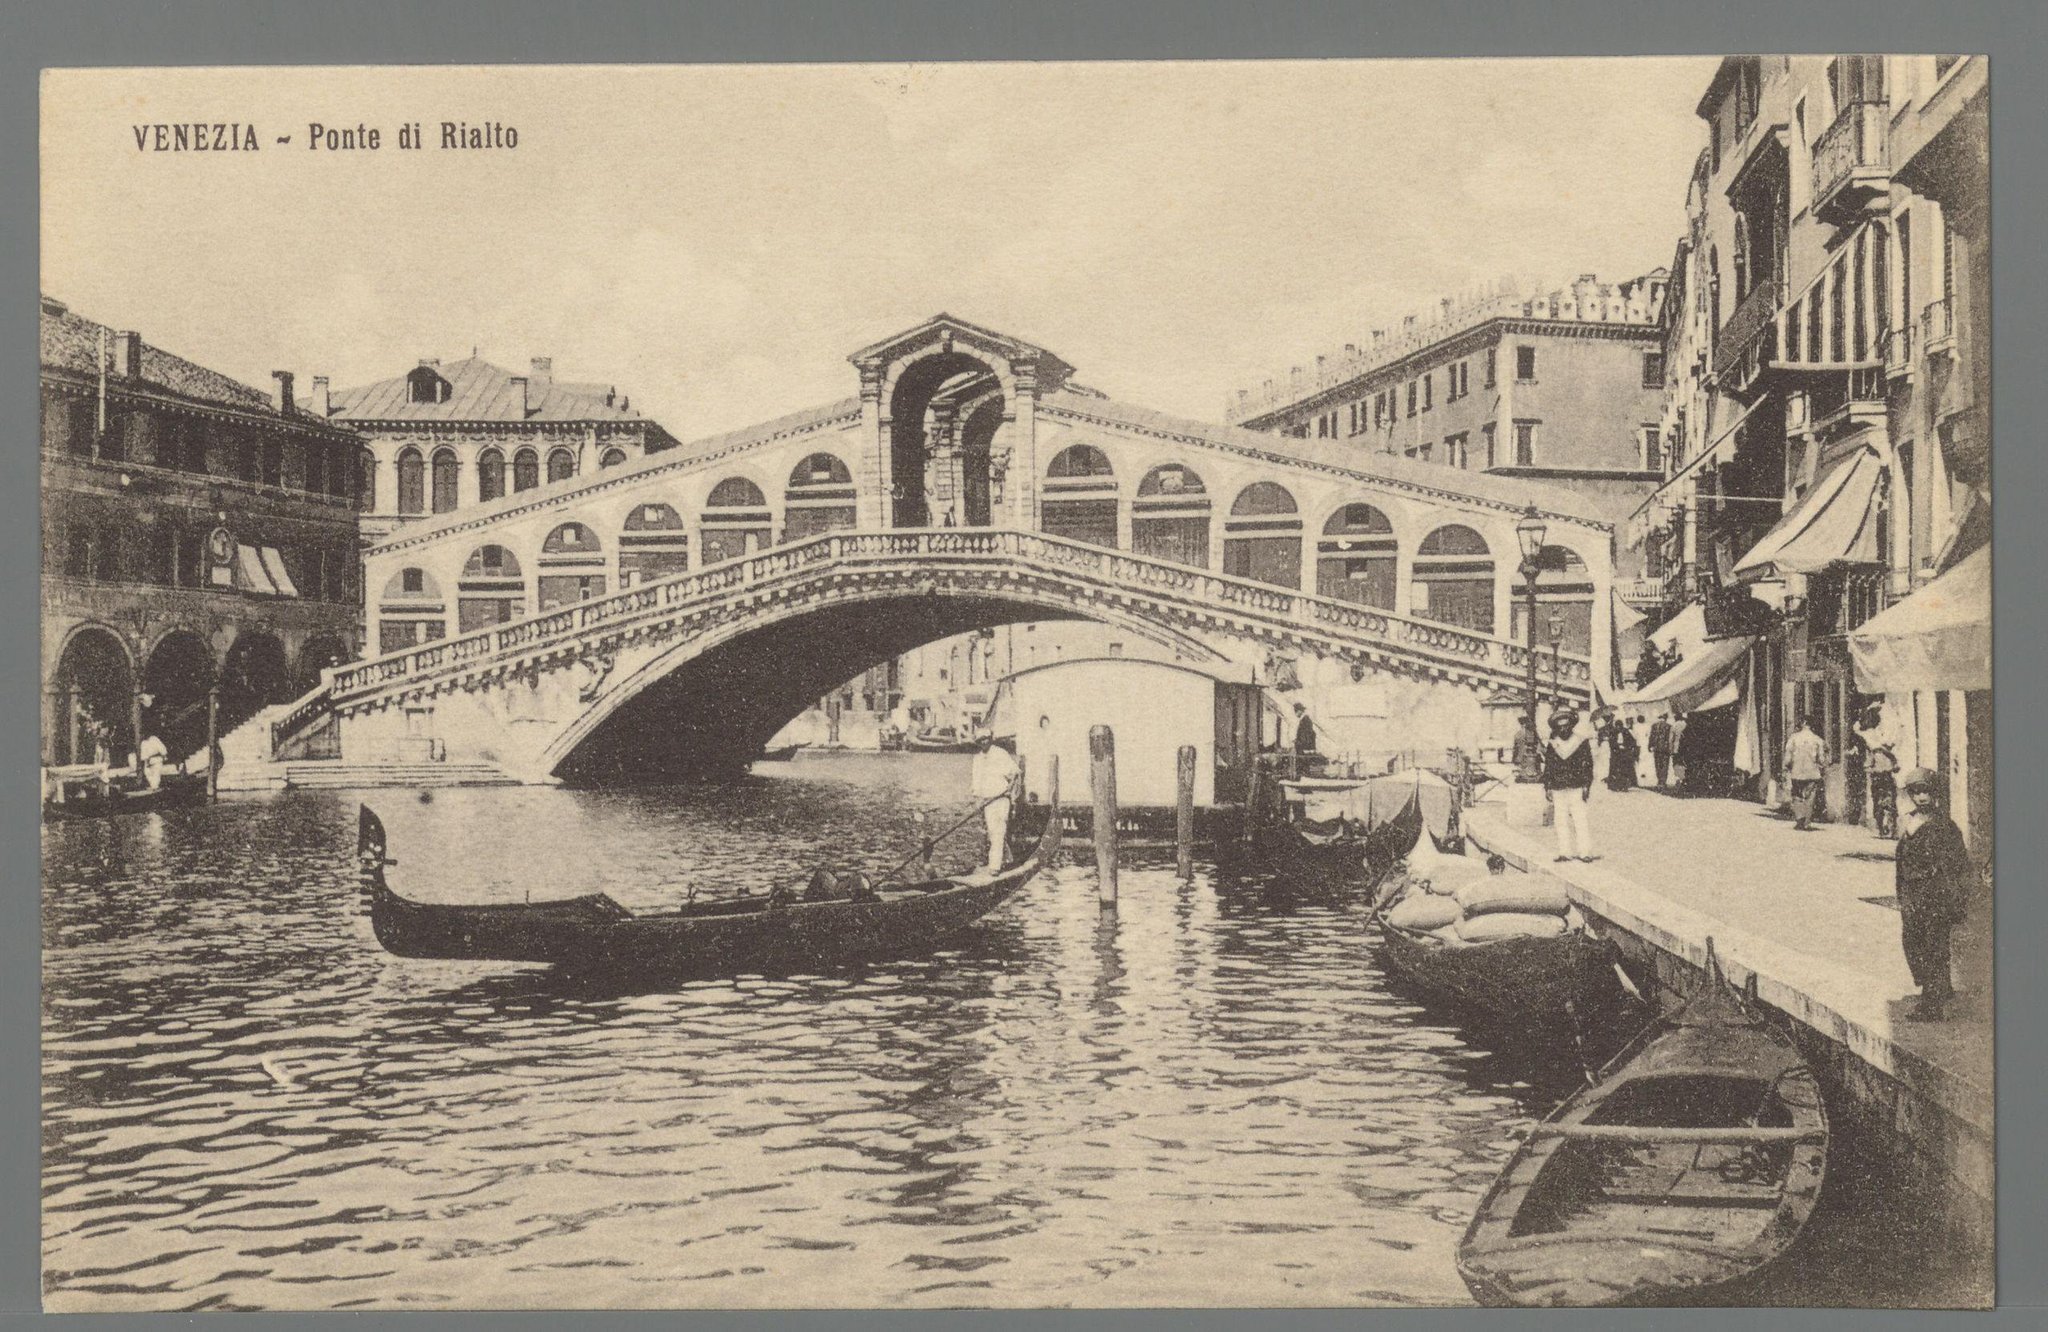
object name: photomechanical print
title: Venezia. Ponte di Rialto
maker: Anonymous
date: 1906-1920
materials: cardboard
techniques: photograph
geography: venice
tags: bridge in city across river, canal, etc. (+ city(-scape) with figures, staffage), canal